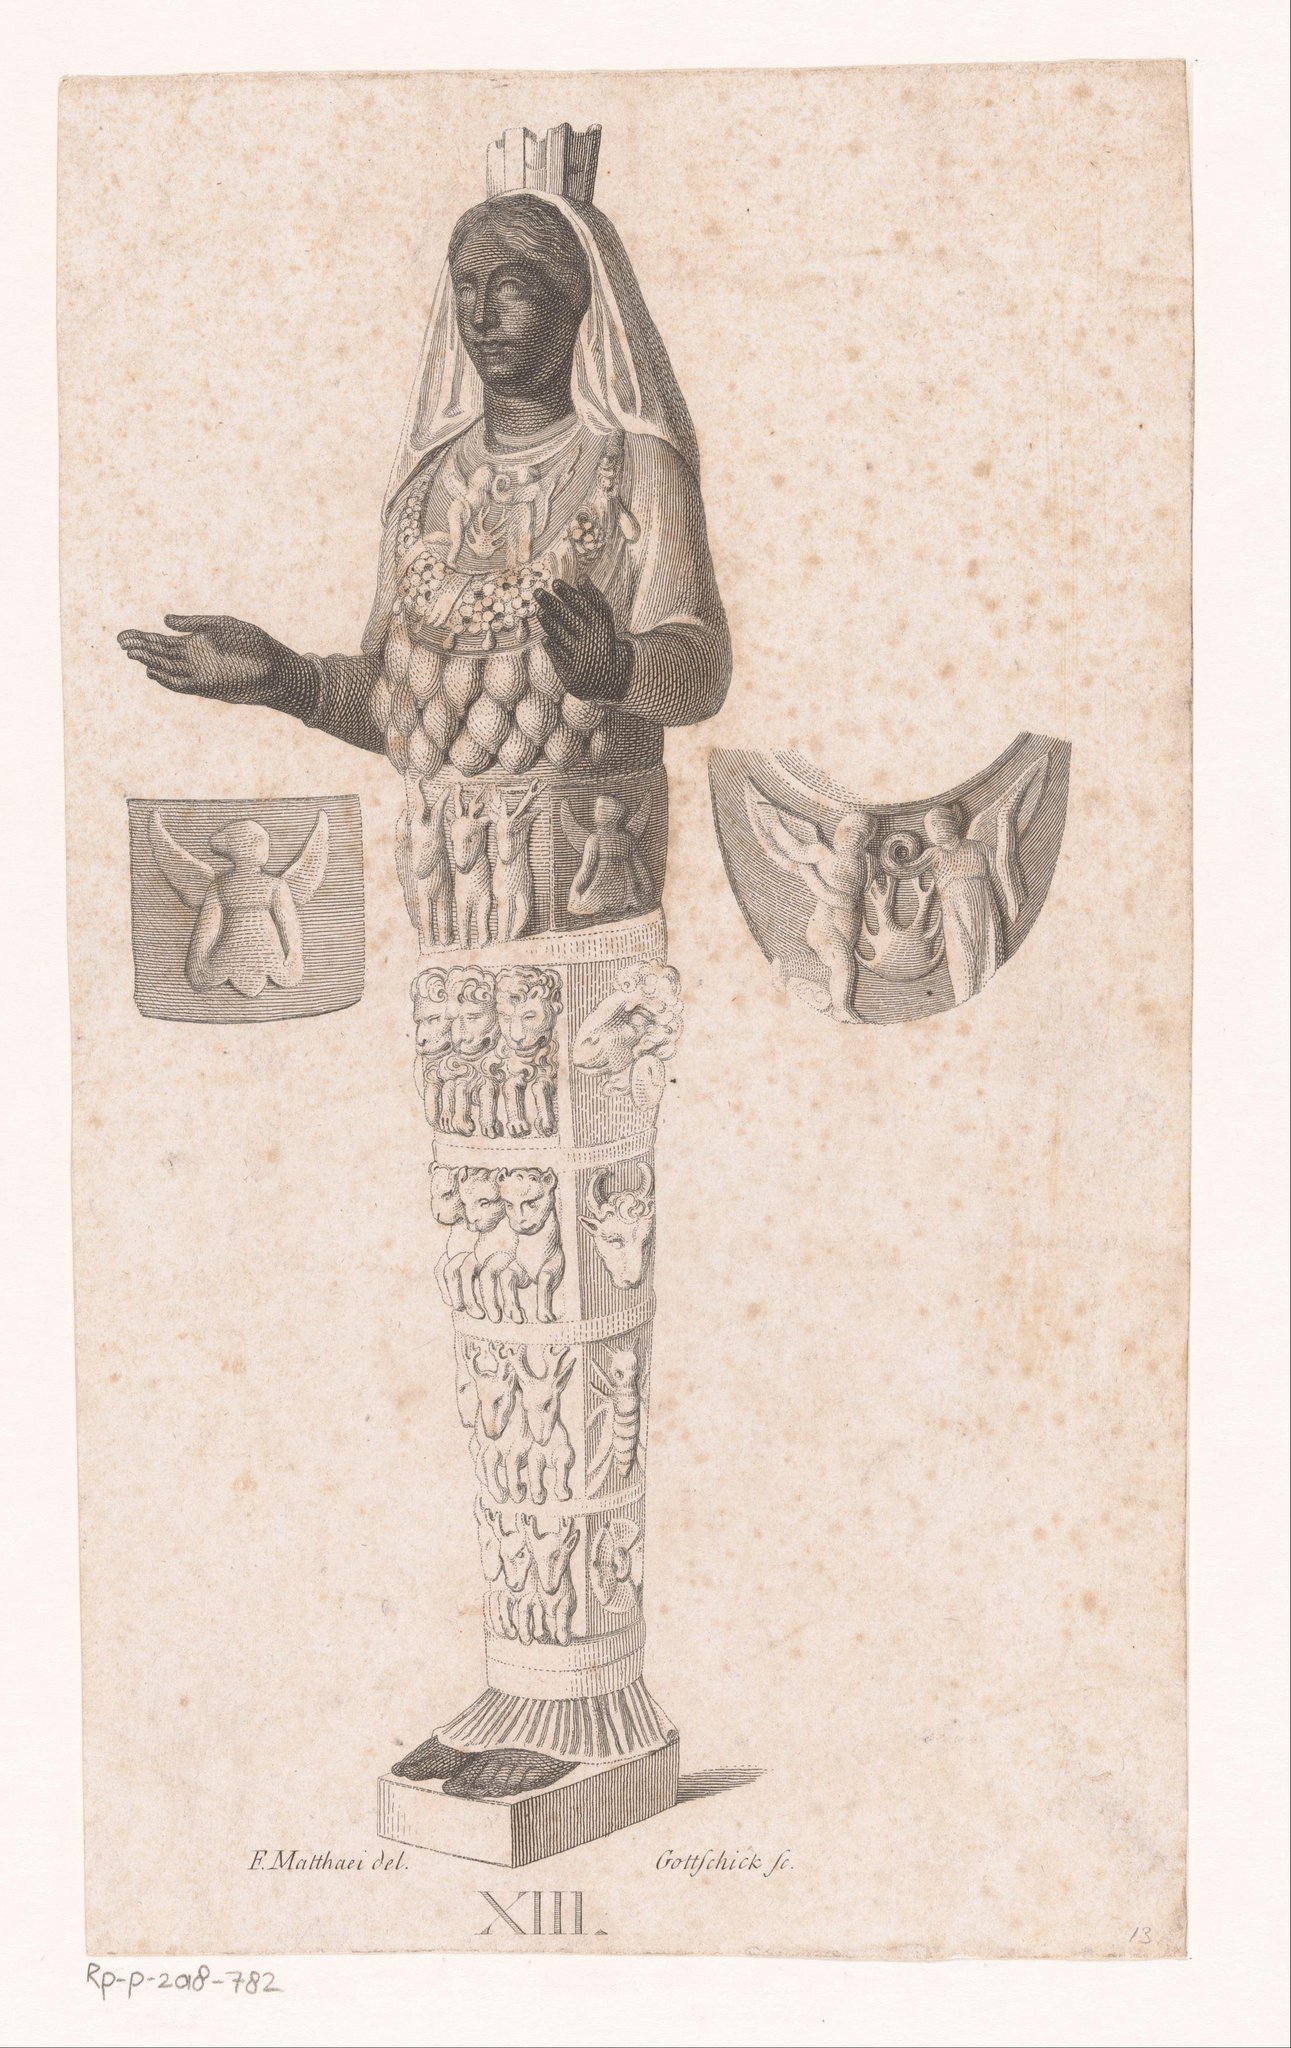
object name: print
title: Vruchtbaarheidsbeeld van Artemis van Efeze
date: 1787-1844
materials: paper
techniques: engraving, etching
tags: breasts, (story of) diana (artemis), other gods of fertility, monument, statue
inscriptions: collector's mark: Lugt 2228